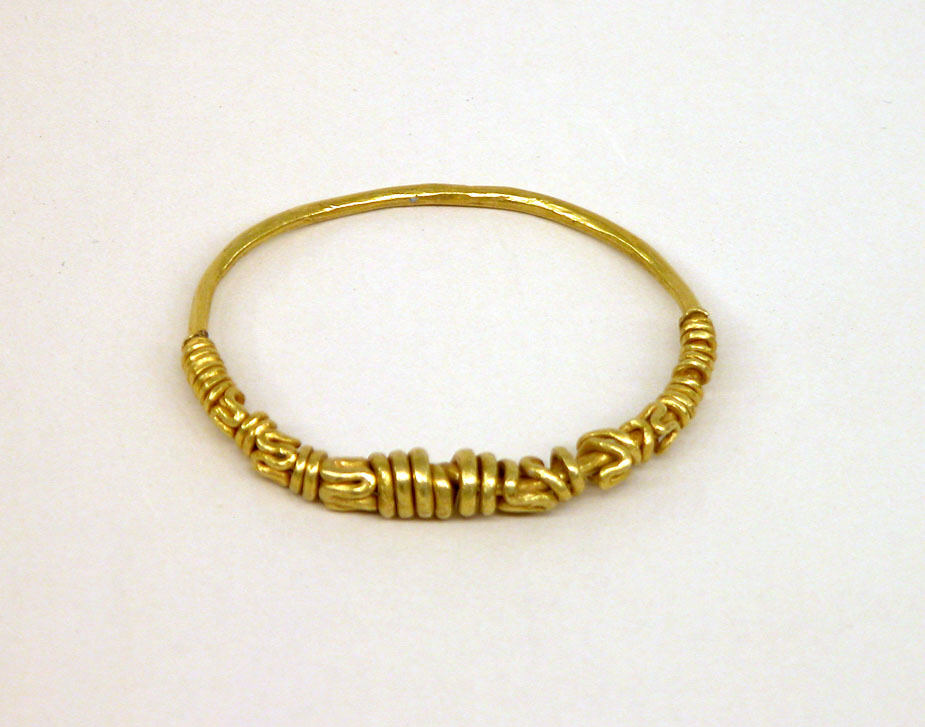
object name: bracelet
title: Small Bracelet of Twisted Wire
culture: indonesian, javanese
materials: gold